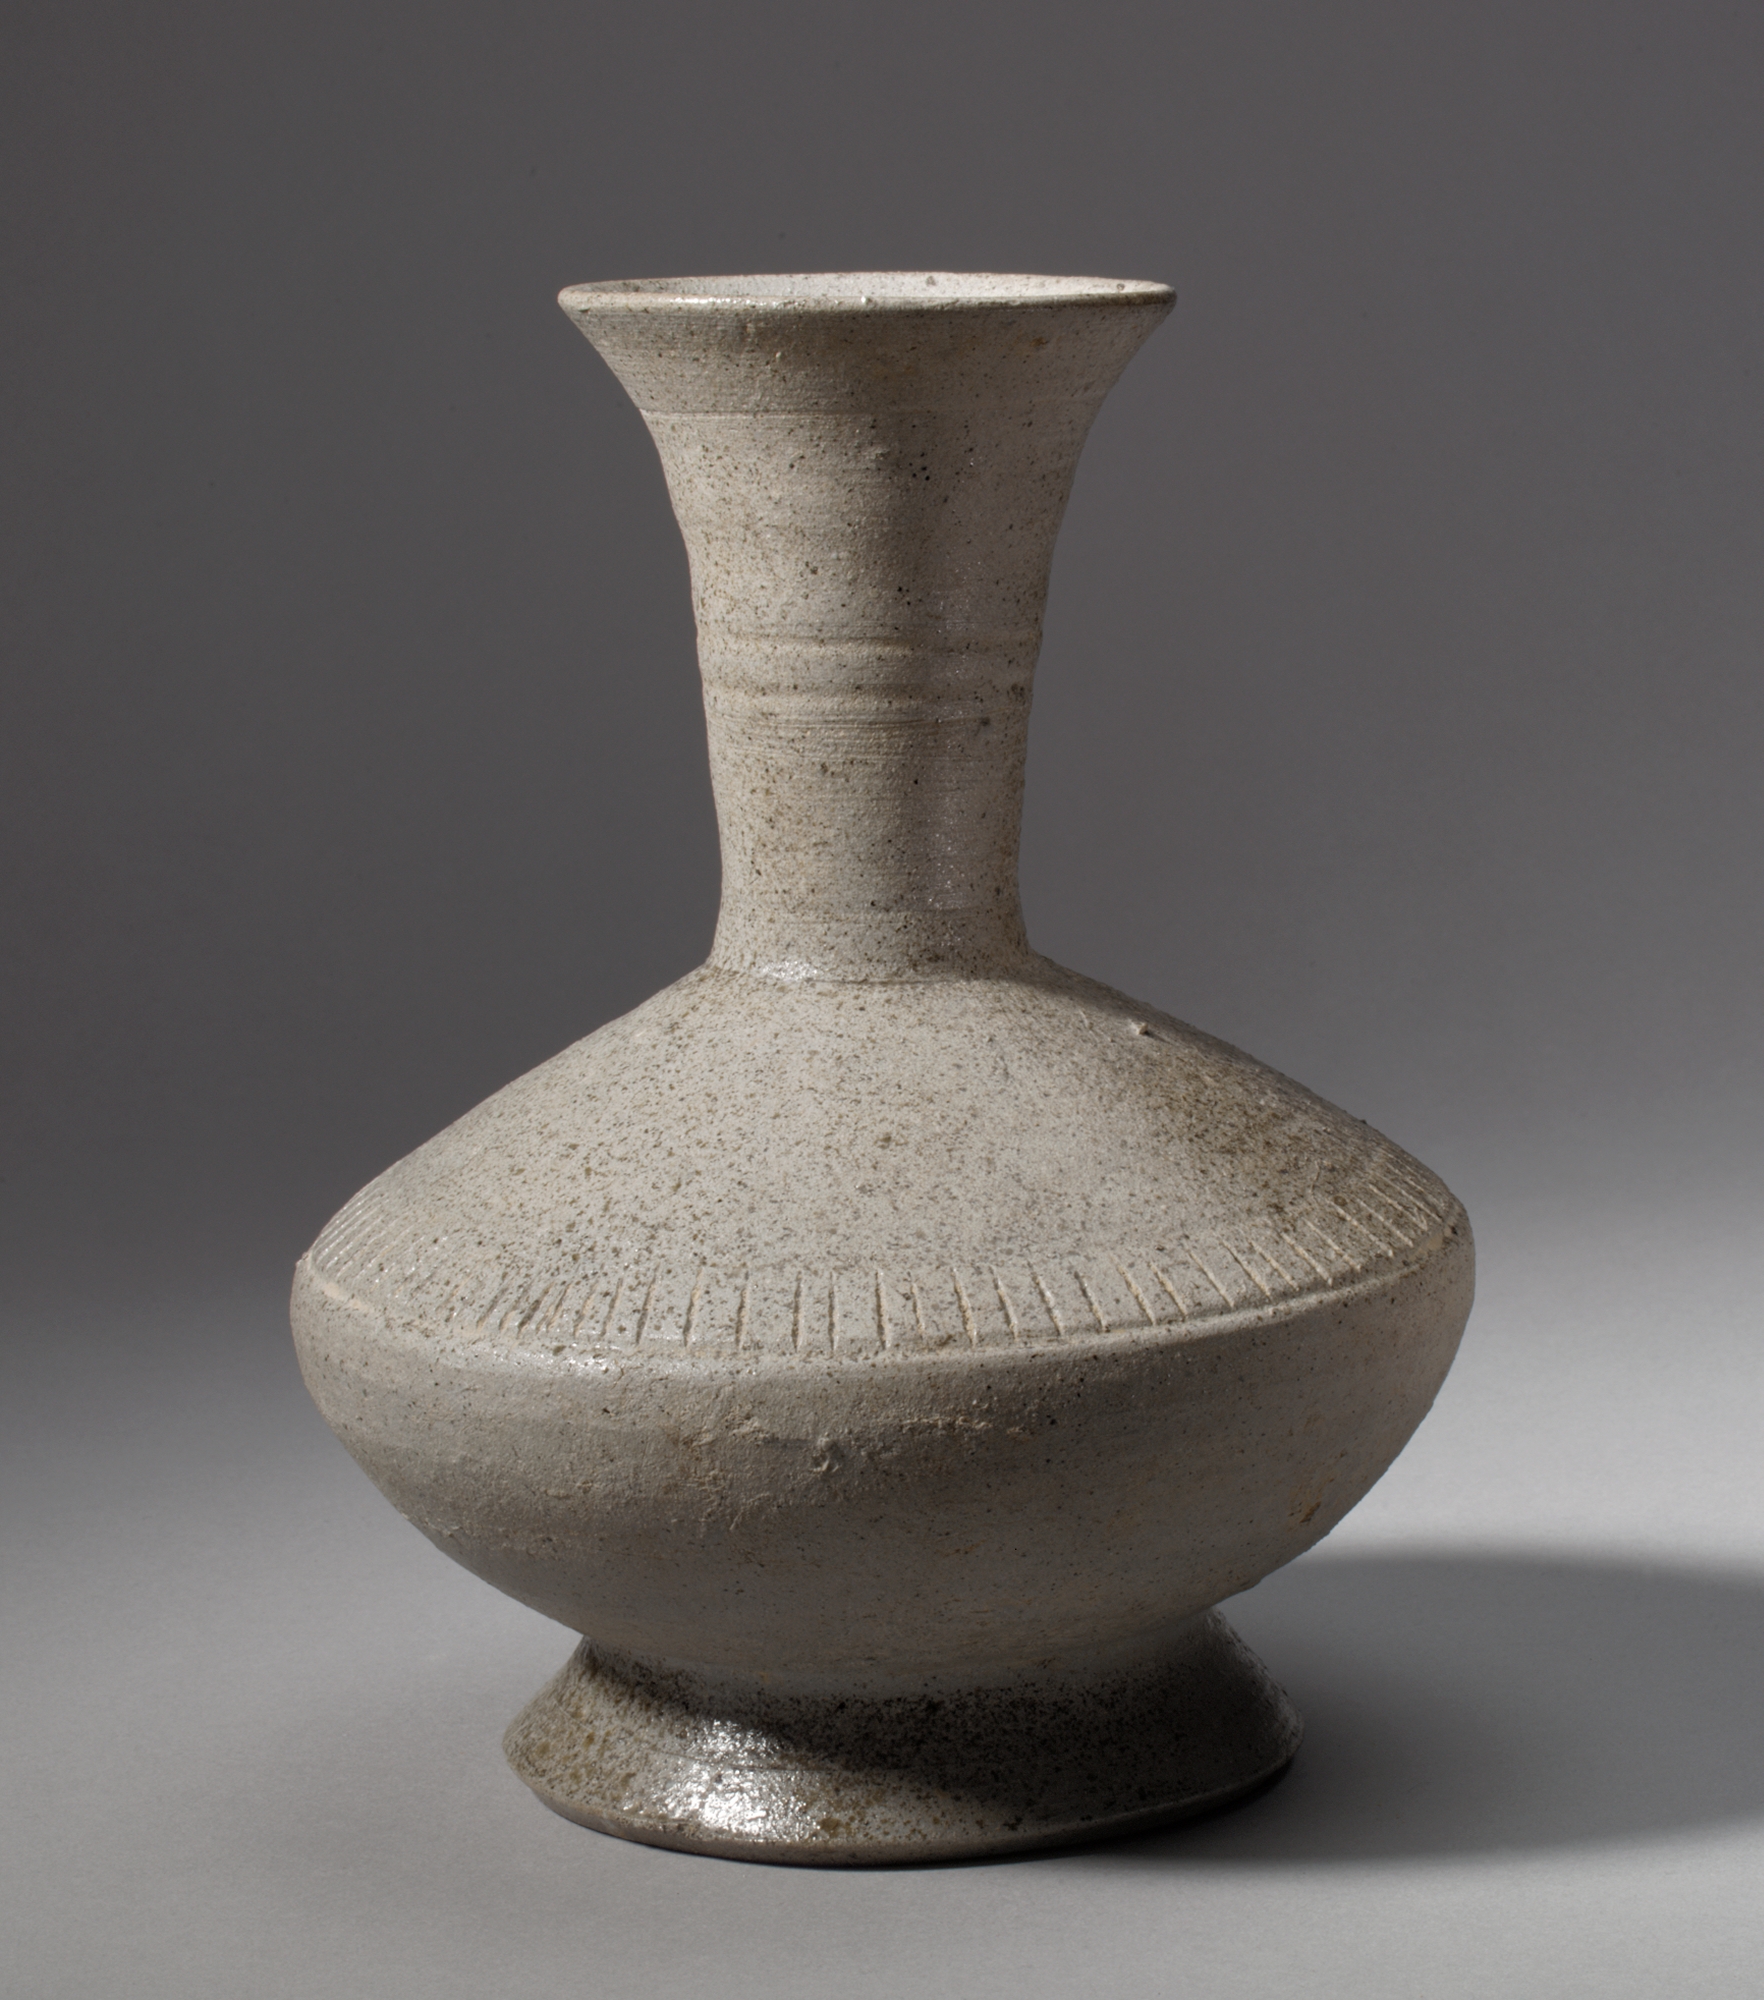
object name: bottle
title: Long-Necked Bottle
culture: japanese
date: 701-800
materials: wood, glaze, stoneware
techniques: incising